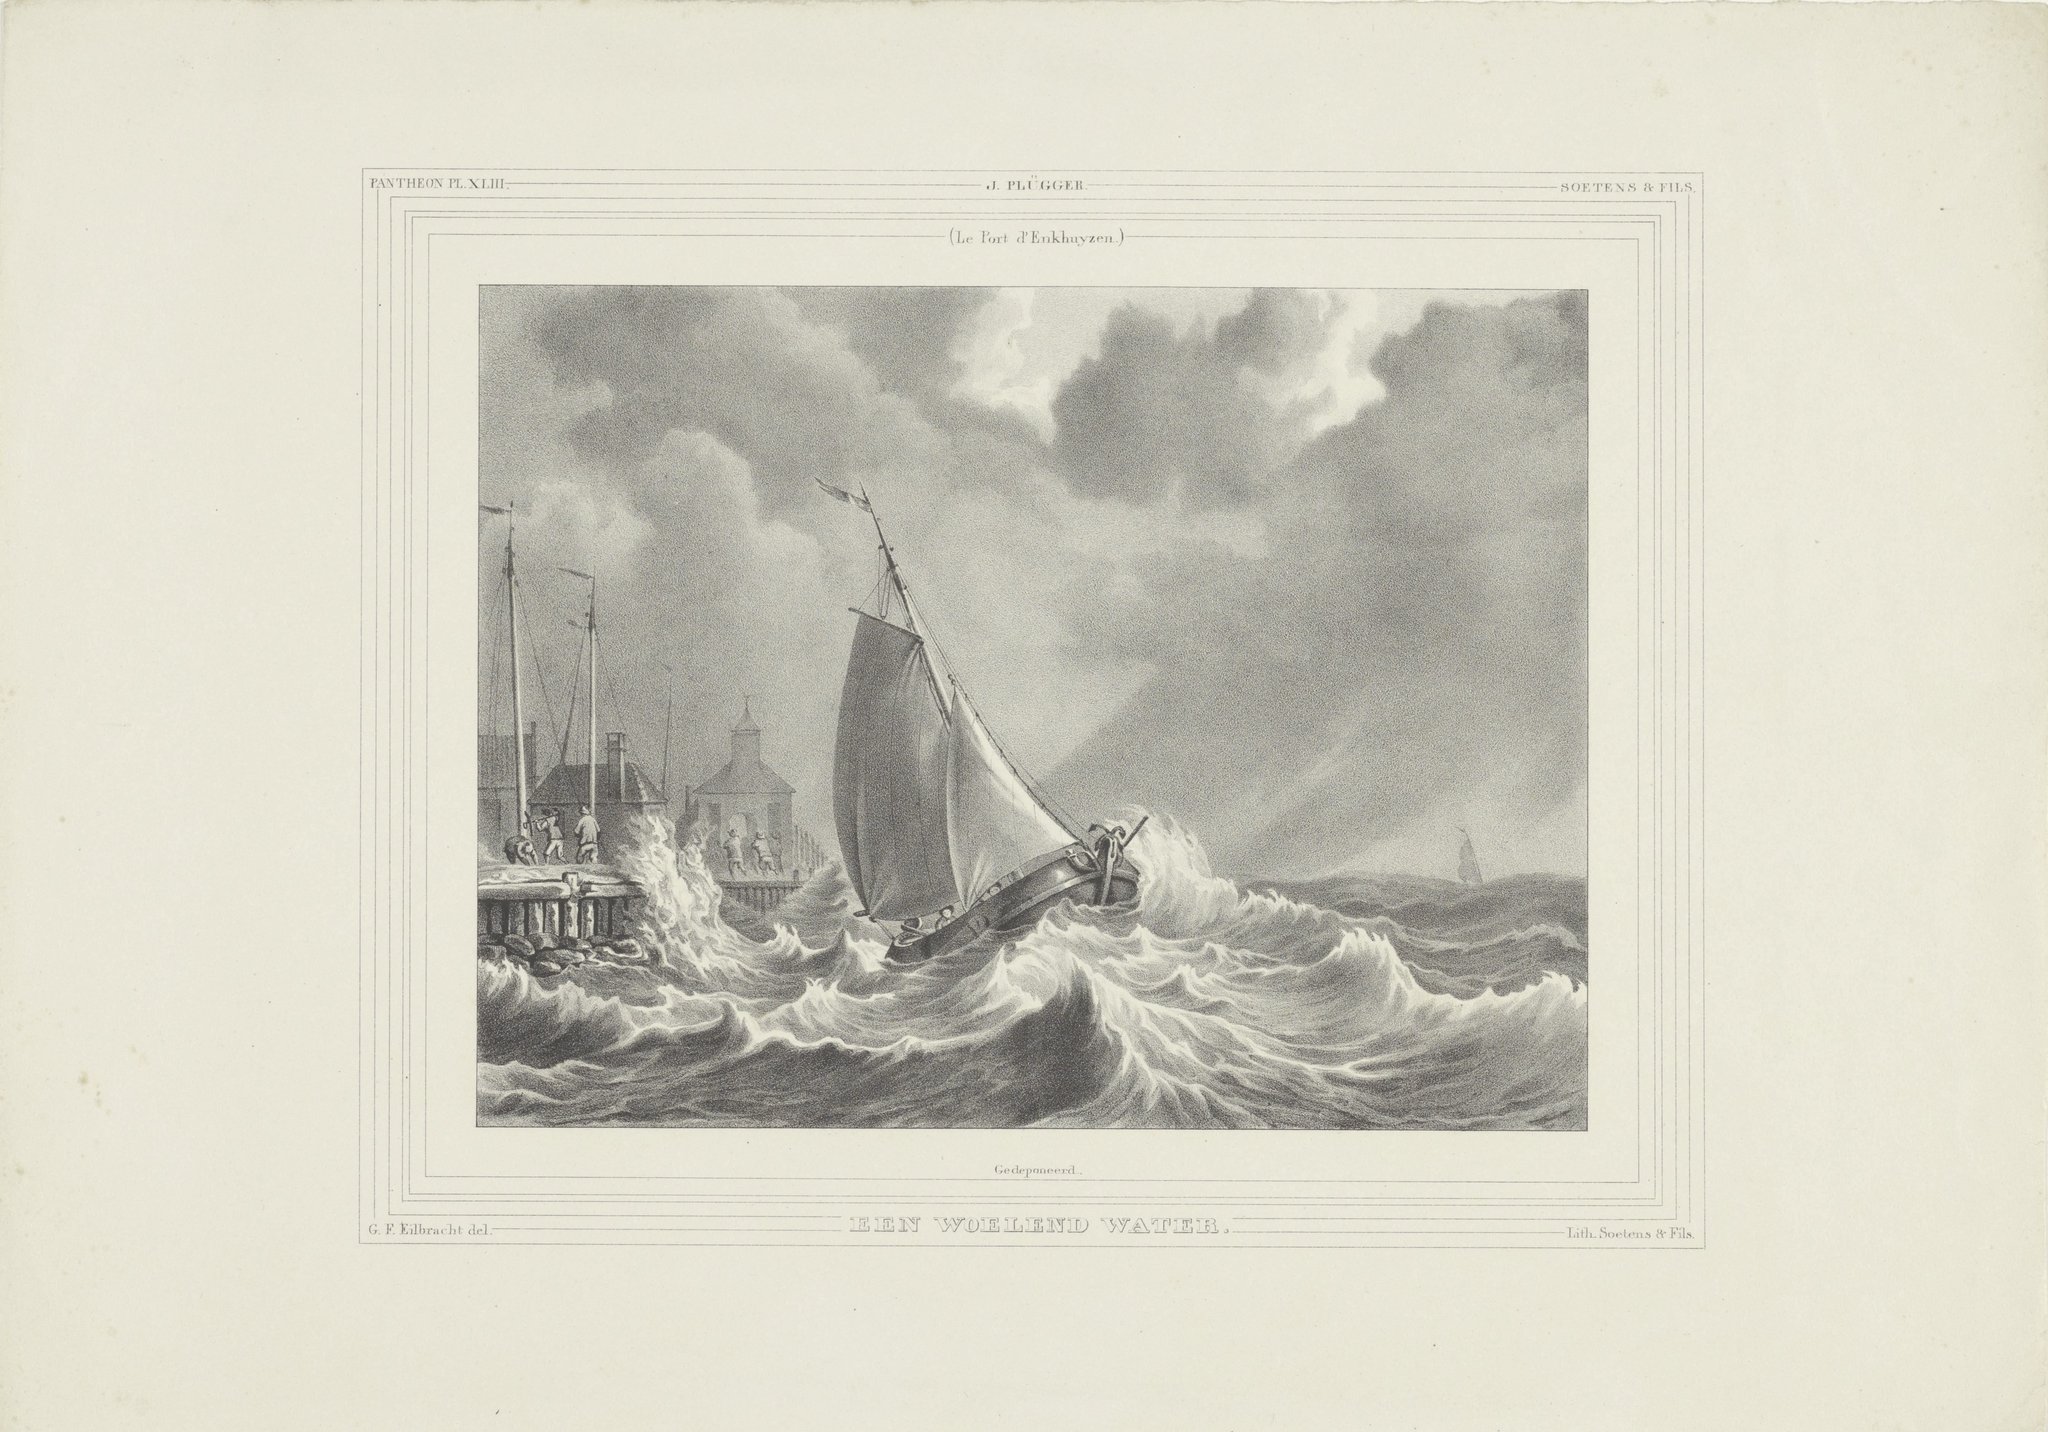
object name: print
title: Een woelend water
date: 1837-1840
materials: paper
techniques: lithograph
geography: the hague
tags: sailing-ship, sailing-boat, pier, quay, wharf, storm at sea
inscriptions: collector's mark: Lugt 2228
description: Het water klotst hoog tegen de pier waar figuren aan het werk zijn. Vlakbij helt een zeilboot ver naar links op de golven. Genummerd linksboven: PANTHEON PL. XLIII.